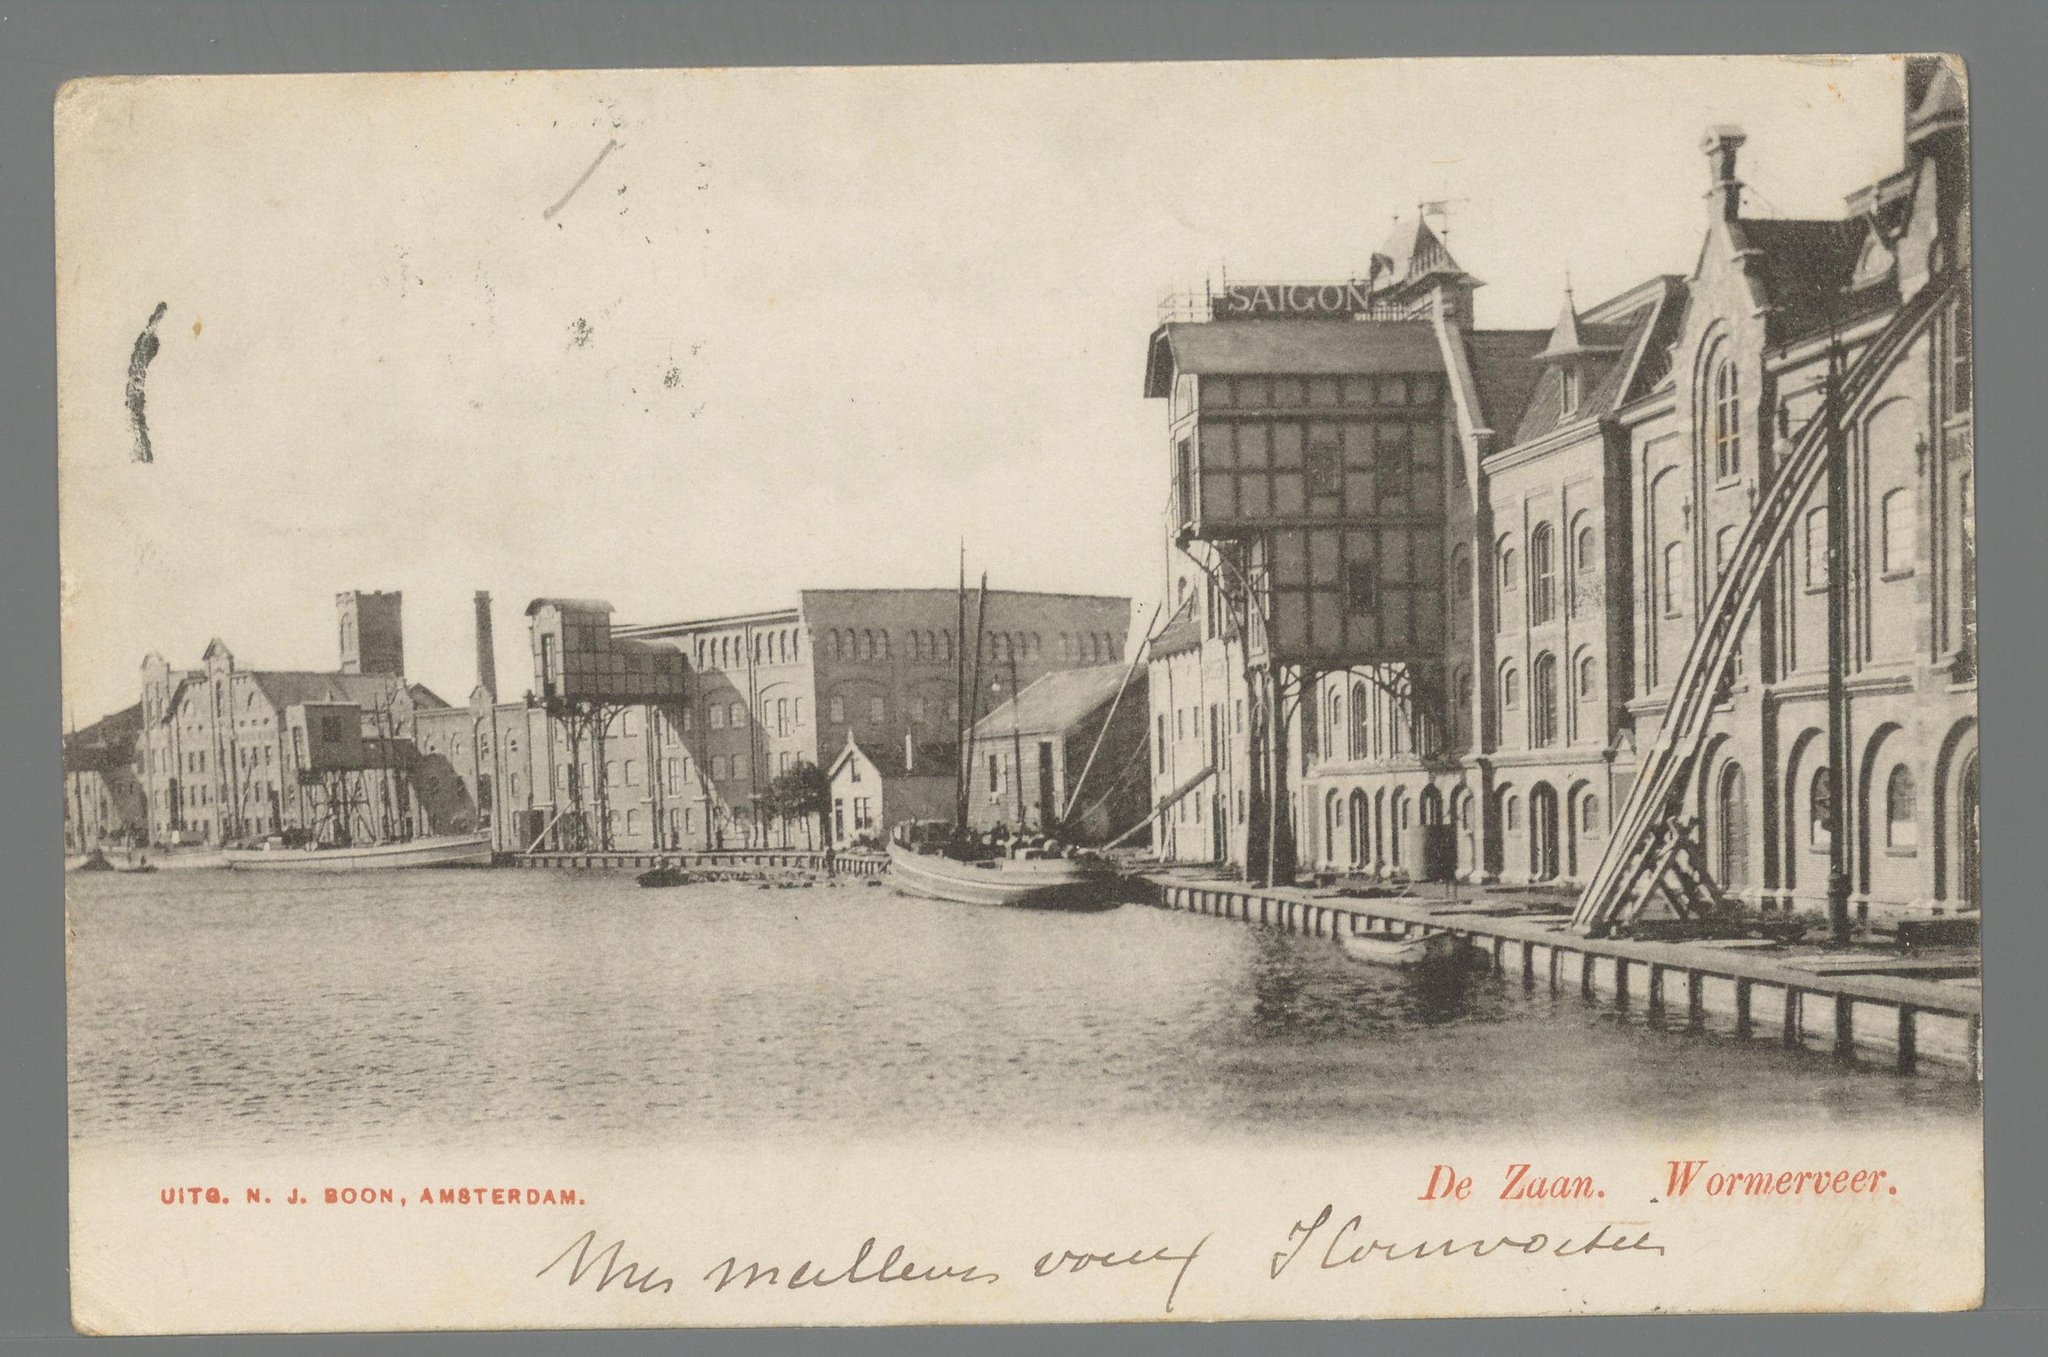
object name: photomechanical print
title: De Zaan. Wormerveer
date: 1897-1905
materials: cardboard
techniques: photograph, writing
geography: amsterdam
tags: city-view, and landscape with man-made constructions, river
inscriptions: postage stamp